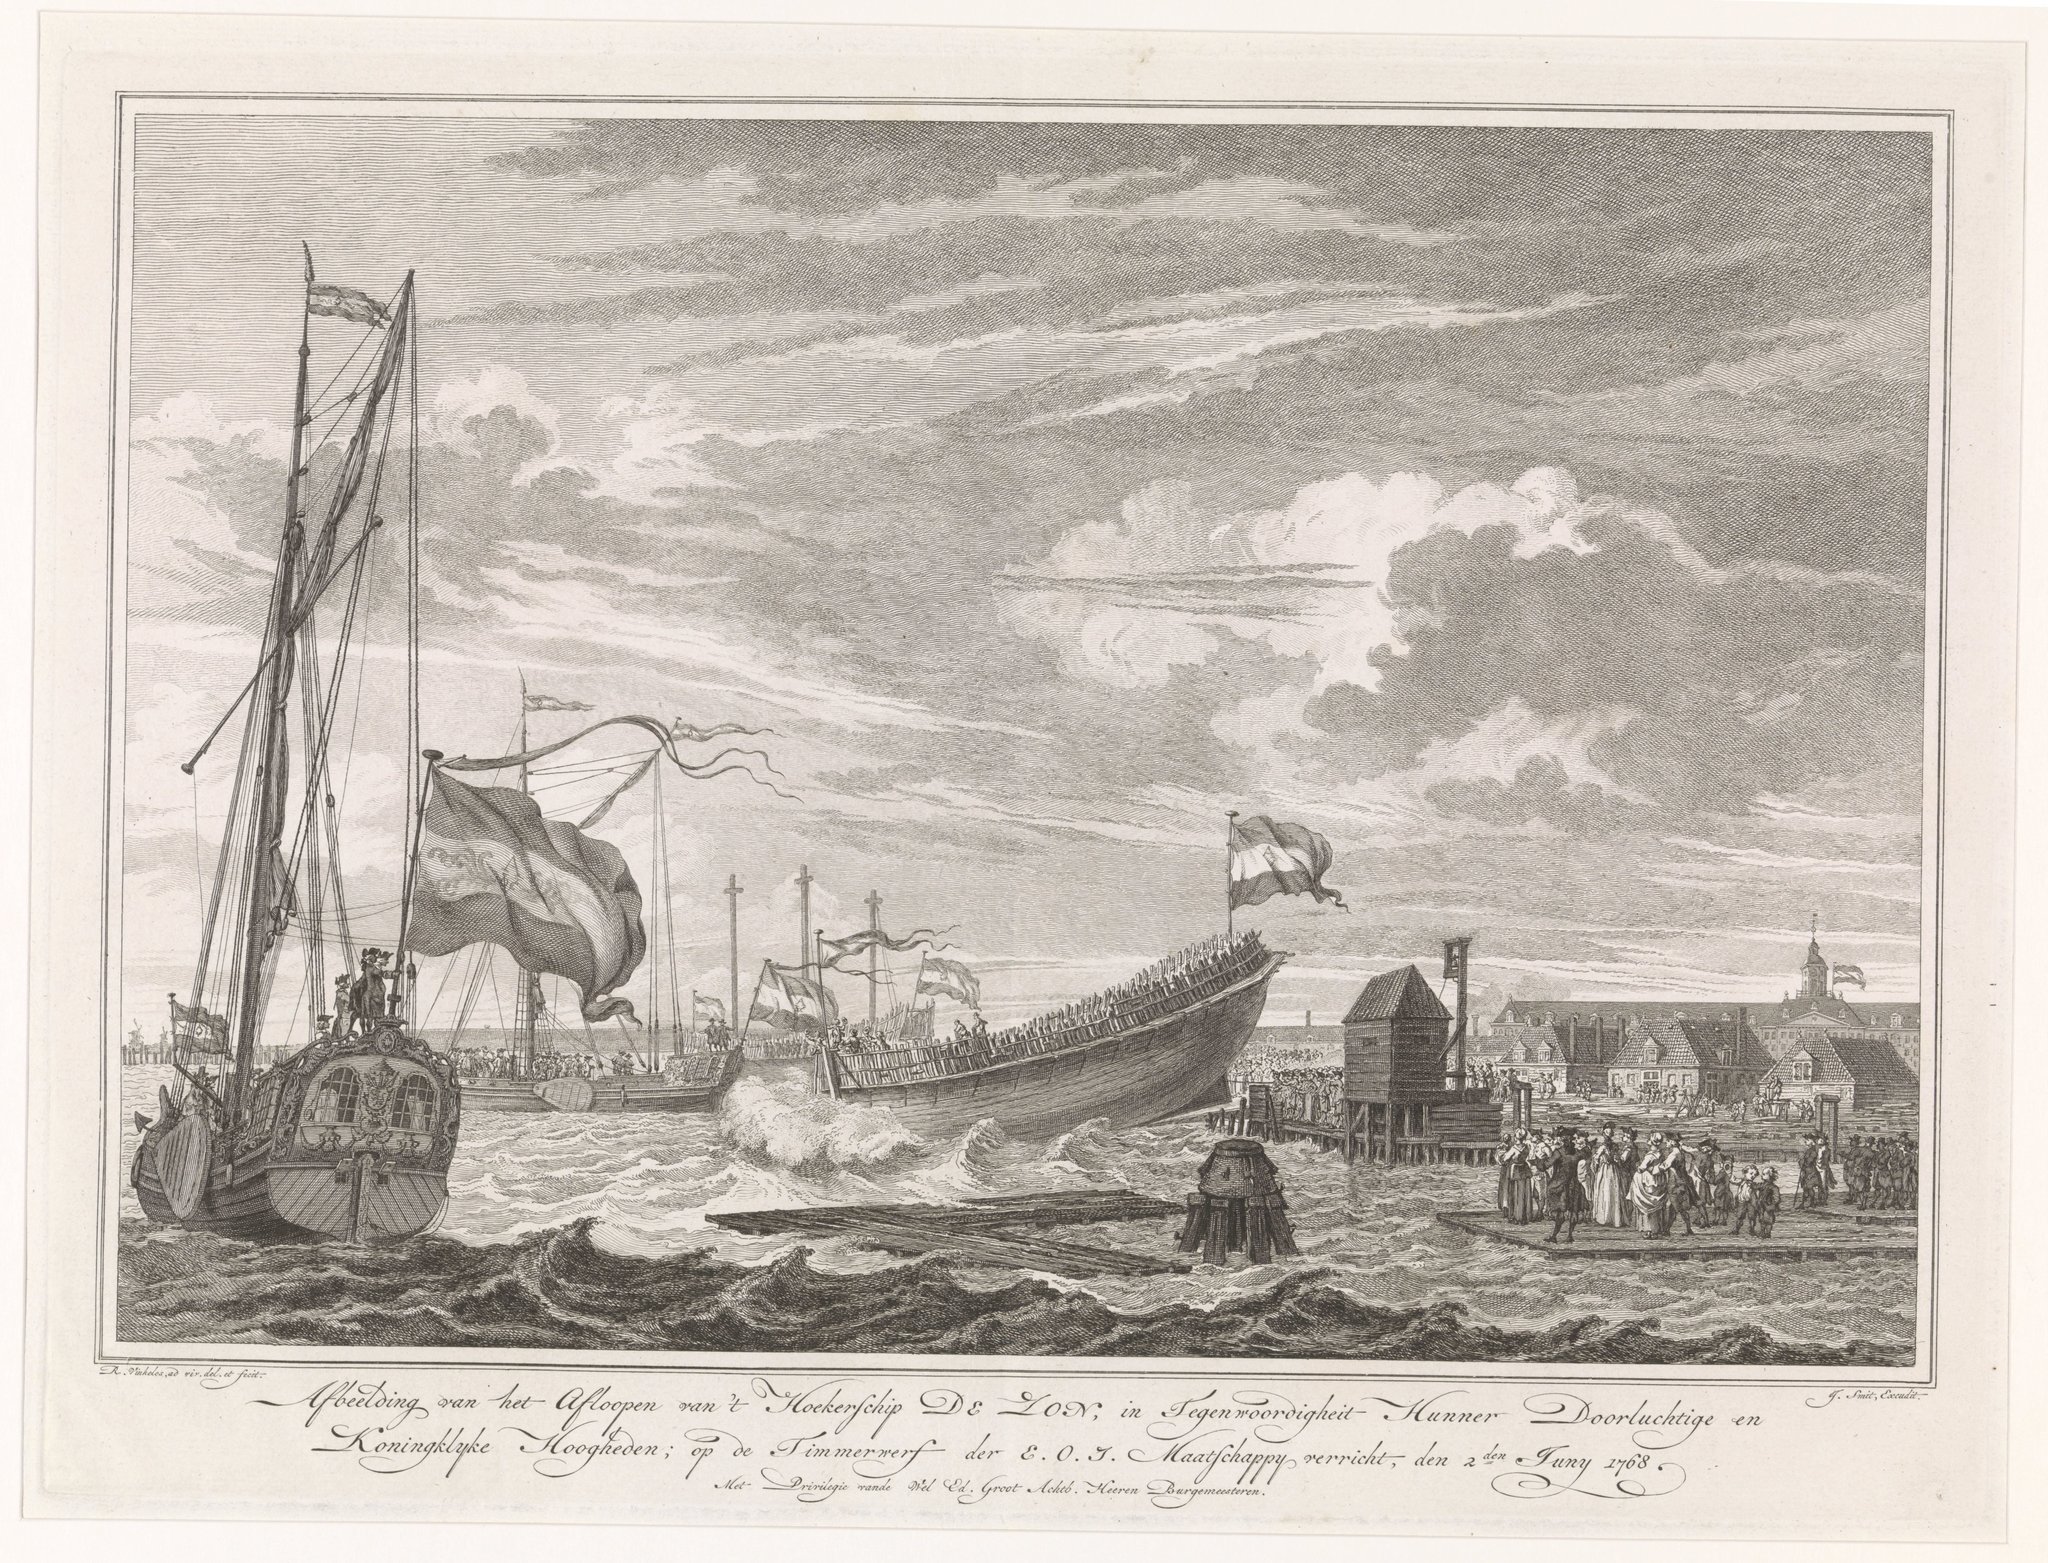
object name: print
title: Afbeelding der Vreugdebedryven en Plegtigheden die by de aankomst en gedurende het verblyf (...) Willem (...) en zyne Gemaalinne (...) zyn voorgevallen te Amsterdam, op maandag, den 30 Mey, en eenige volgende dagen, des jaars 1768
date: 1769-1773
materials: paper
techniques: engraving, etching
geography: northern netherlands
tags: william v (prince of orange), painter, draughtsman, wilhelmina of prussia (princess of orange), public festivities on the occasion of royal events, launching a ship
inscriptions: collector's mark: Lugt 2228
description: Het tewaterlaten of aflopen van het hoekerschip De Zon voor de VOC op de scheepstimmerwerf bij het Oostindisch Zeemagazijn te Amsterdam, in tegenwoordigheid van stadhouder Willem V en prinses Wilhelmina van Pruisen, 2 juni 1768. Onderdeel van een prentserie met titelprent en 14 platen van de inhaling van de prins en prinses te Amsterdam, 30 mei - 4 juni 1768.